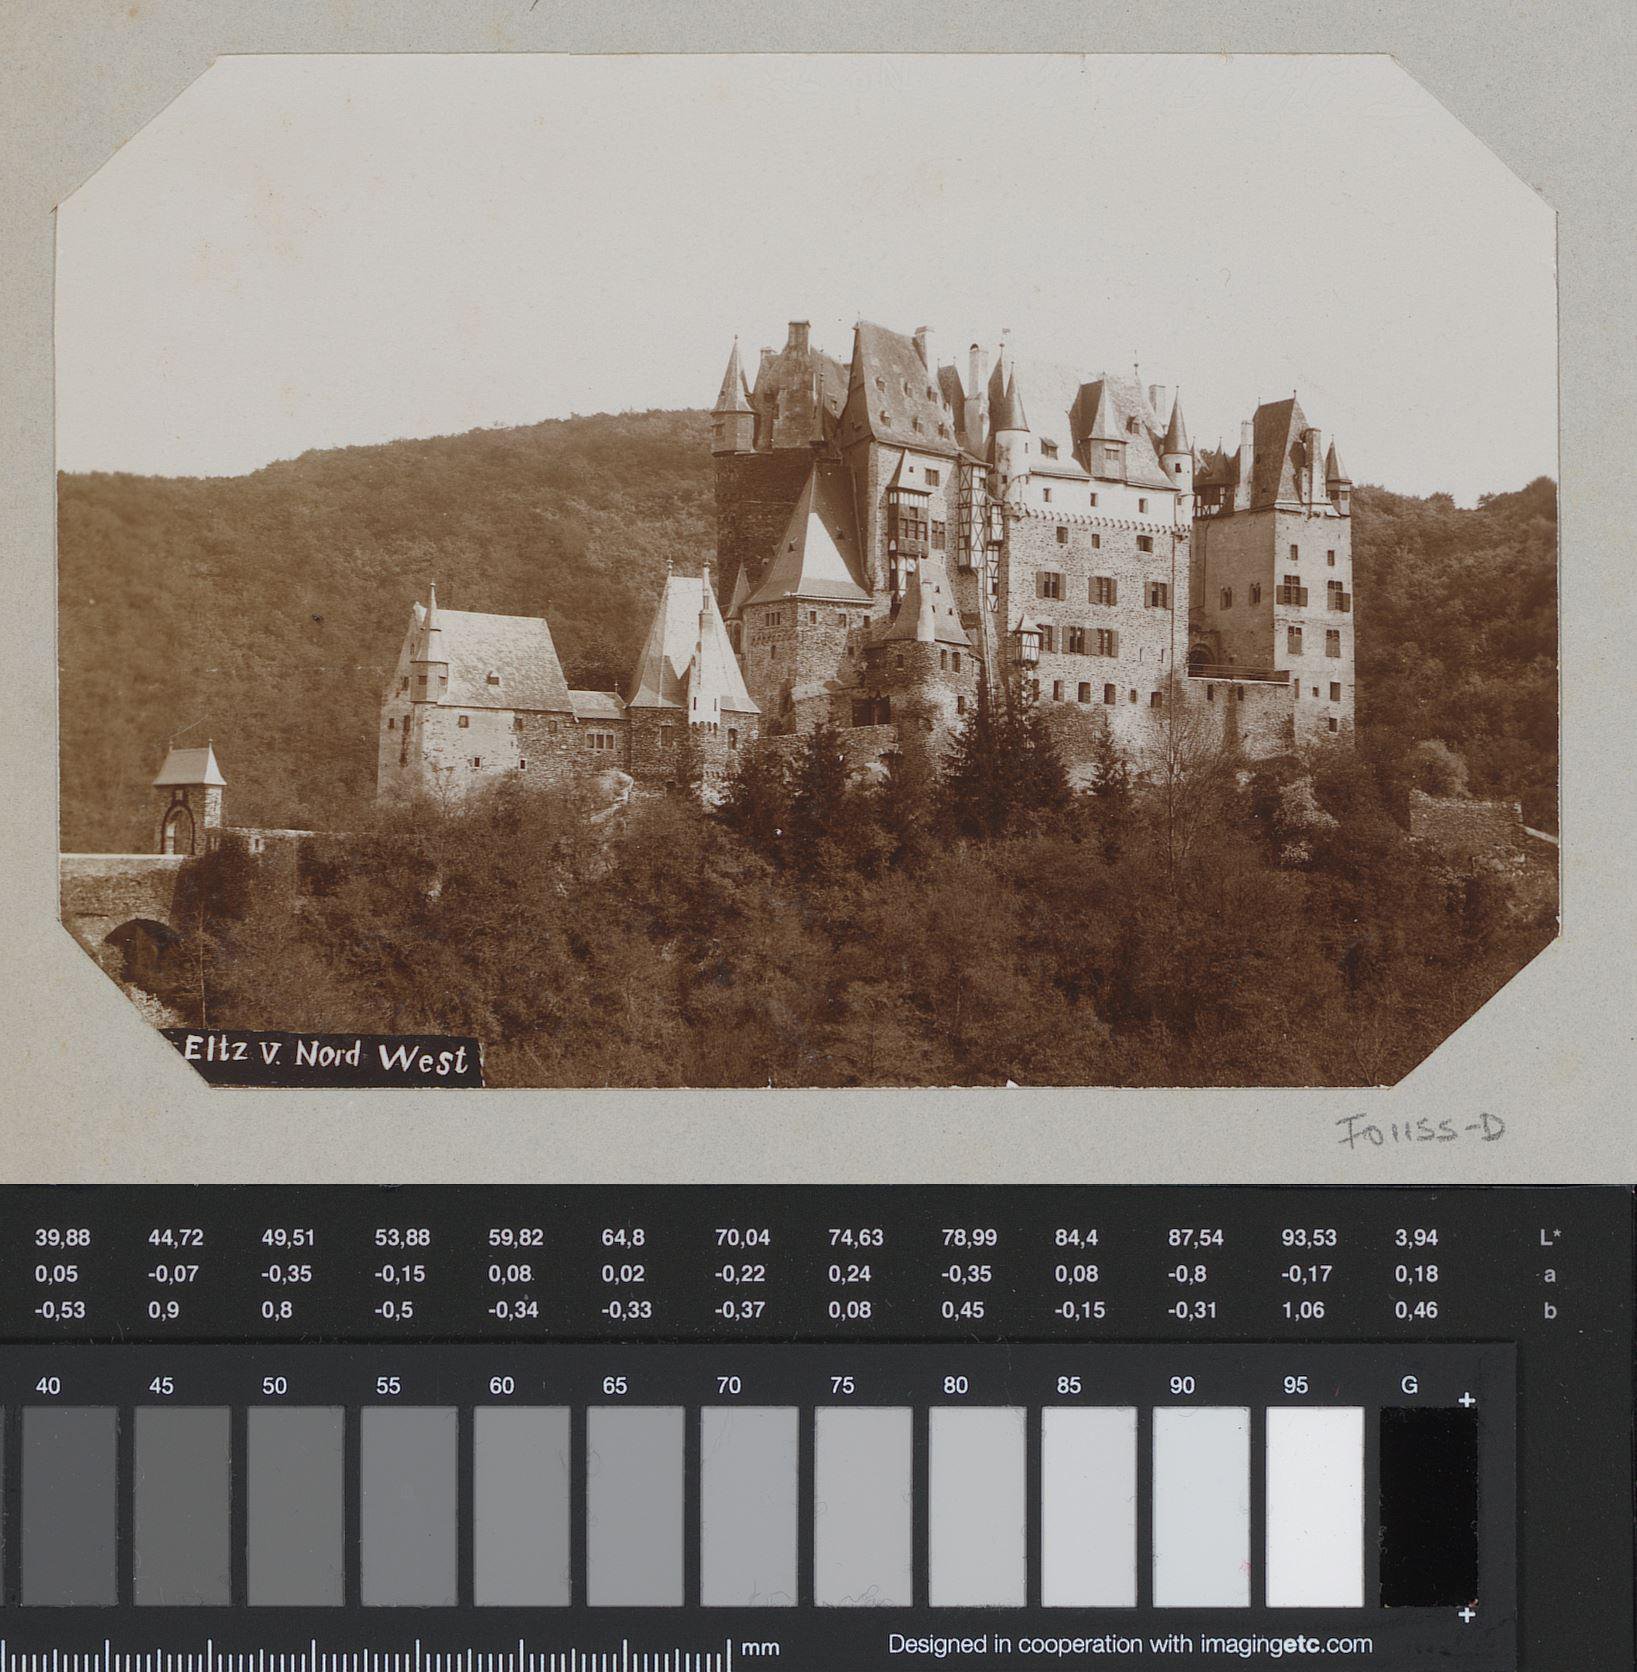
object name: album leaf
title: Gezicht op de noordwestzijde van Burg Eltz te Wierschem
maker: Anonymous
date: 1890-1896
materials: photographic support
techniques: collodion silver print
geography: wierschem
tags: landscape with tower or castle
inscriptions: annotation: ‘Burg Eltz bij Wierschem’, inscription: ‘Burg Eltz v. Nord West’